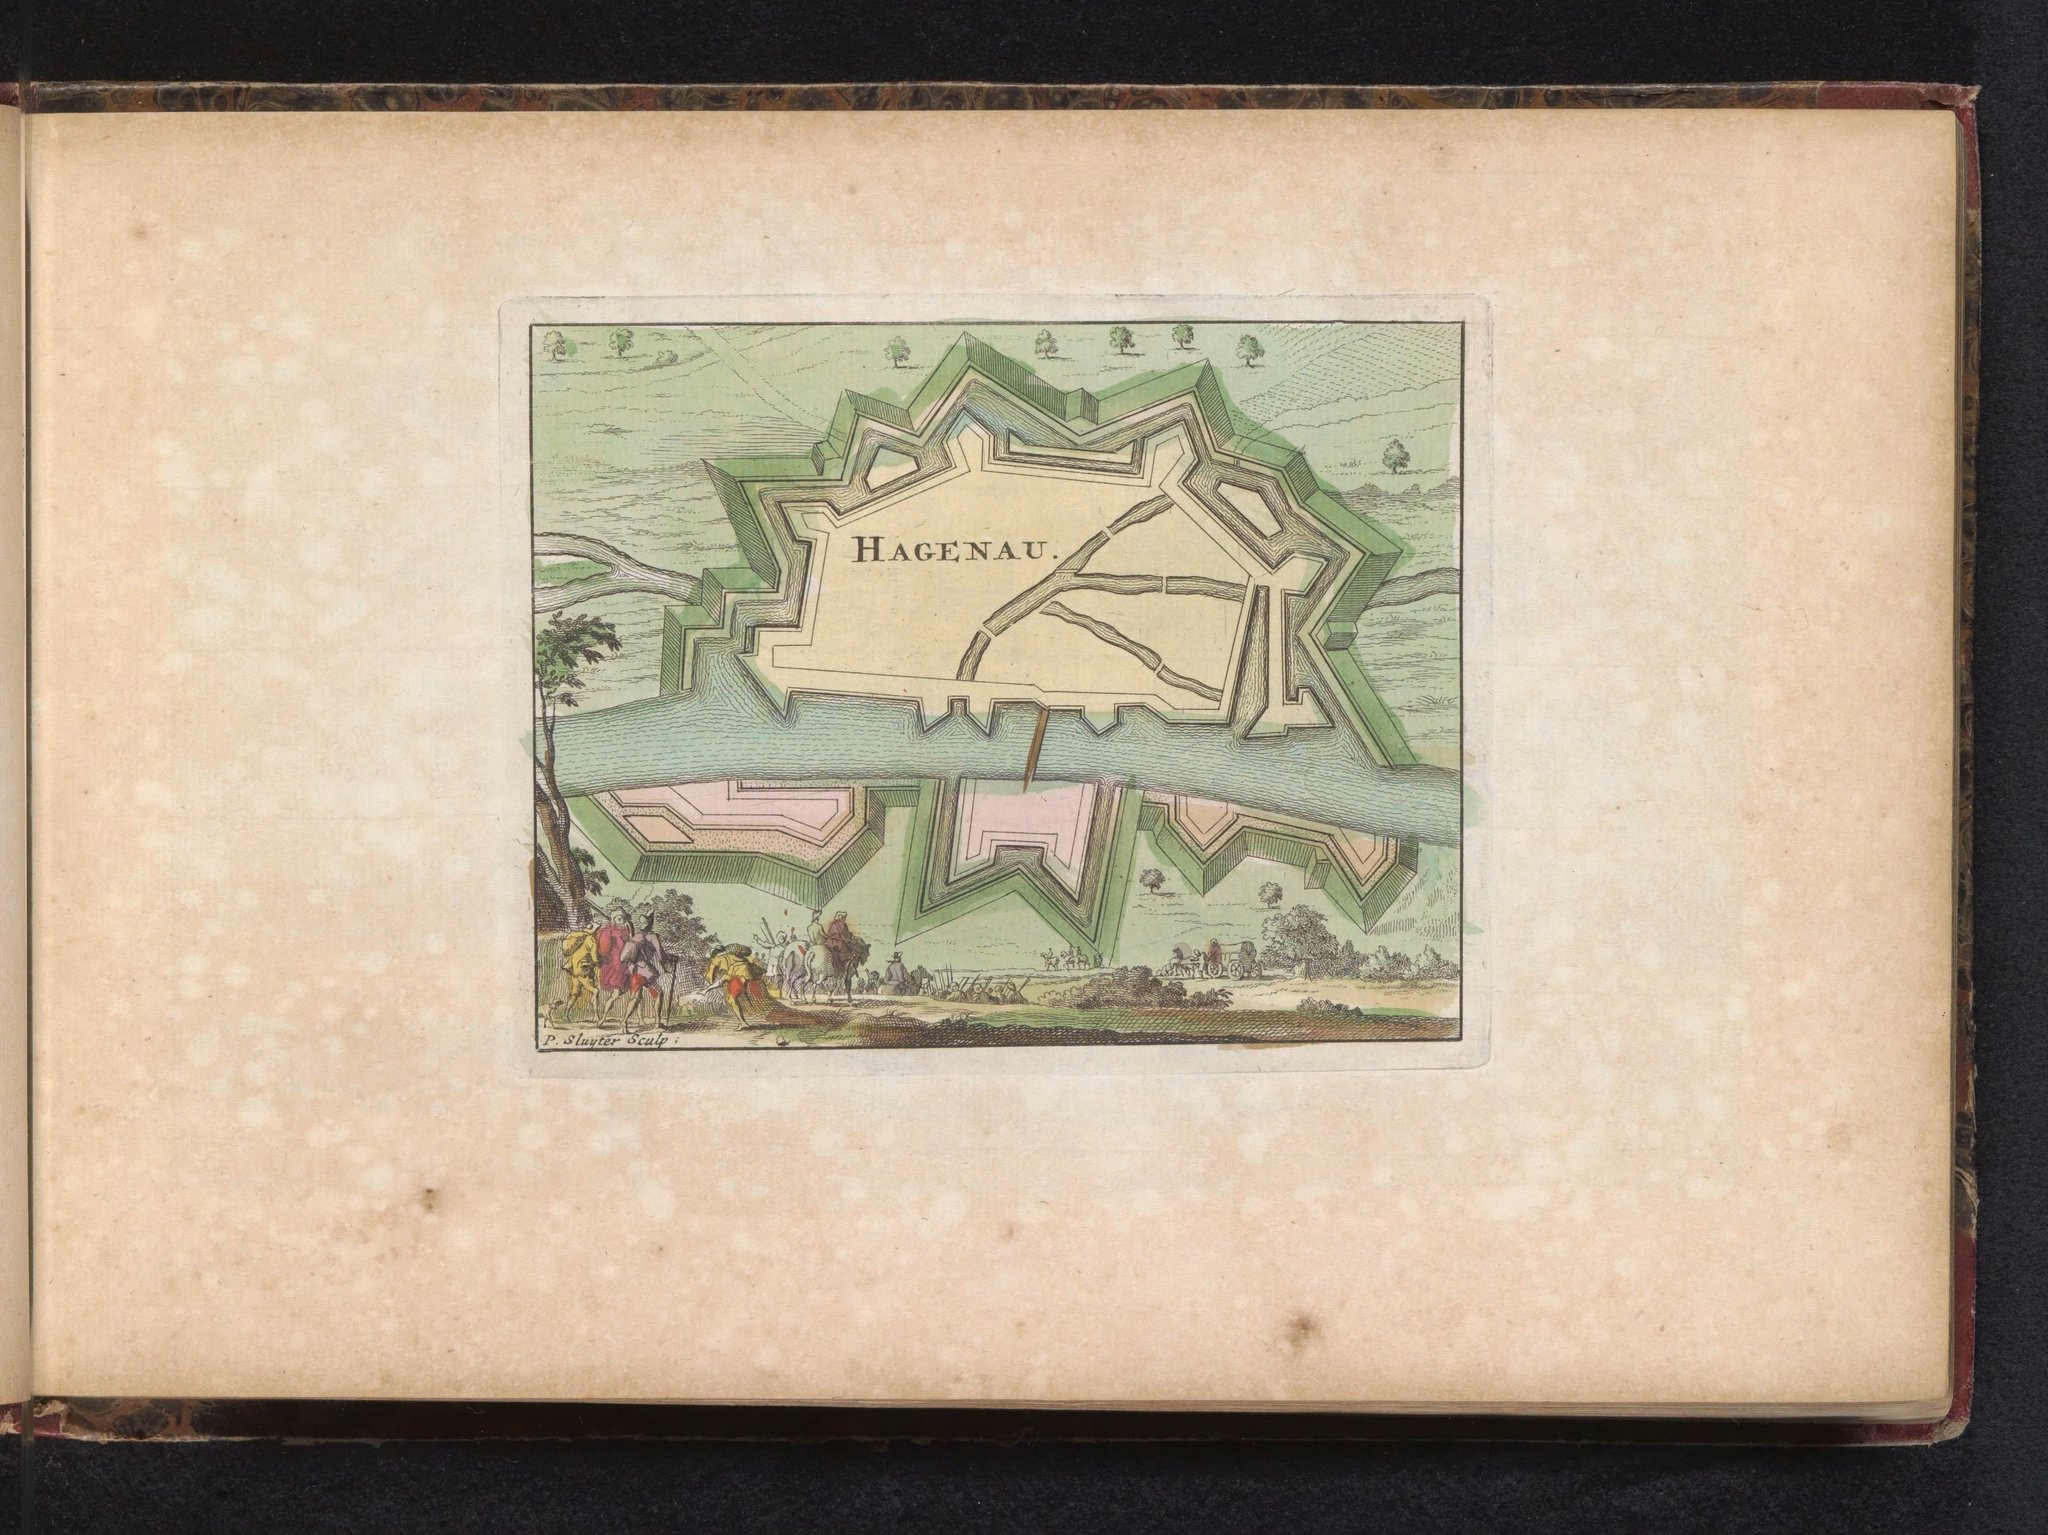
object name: map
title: Hagenau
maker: zacharias chatelain (ii)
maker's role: bookseller, publisher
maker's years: 1690-1754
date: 1735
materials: paper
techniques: engraving, etching, hand coloring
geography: amsterdam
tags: fortified city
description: Plattegrond van de versterkingen om de stad Haguenau. Onderaan soldaten in landschap. Onderdeel van een atlas met 223 kaarten van landen en steden en oorlogstaferelen in Europa in de periode ca. 1690-1735.